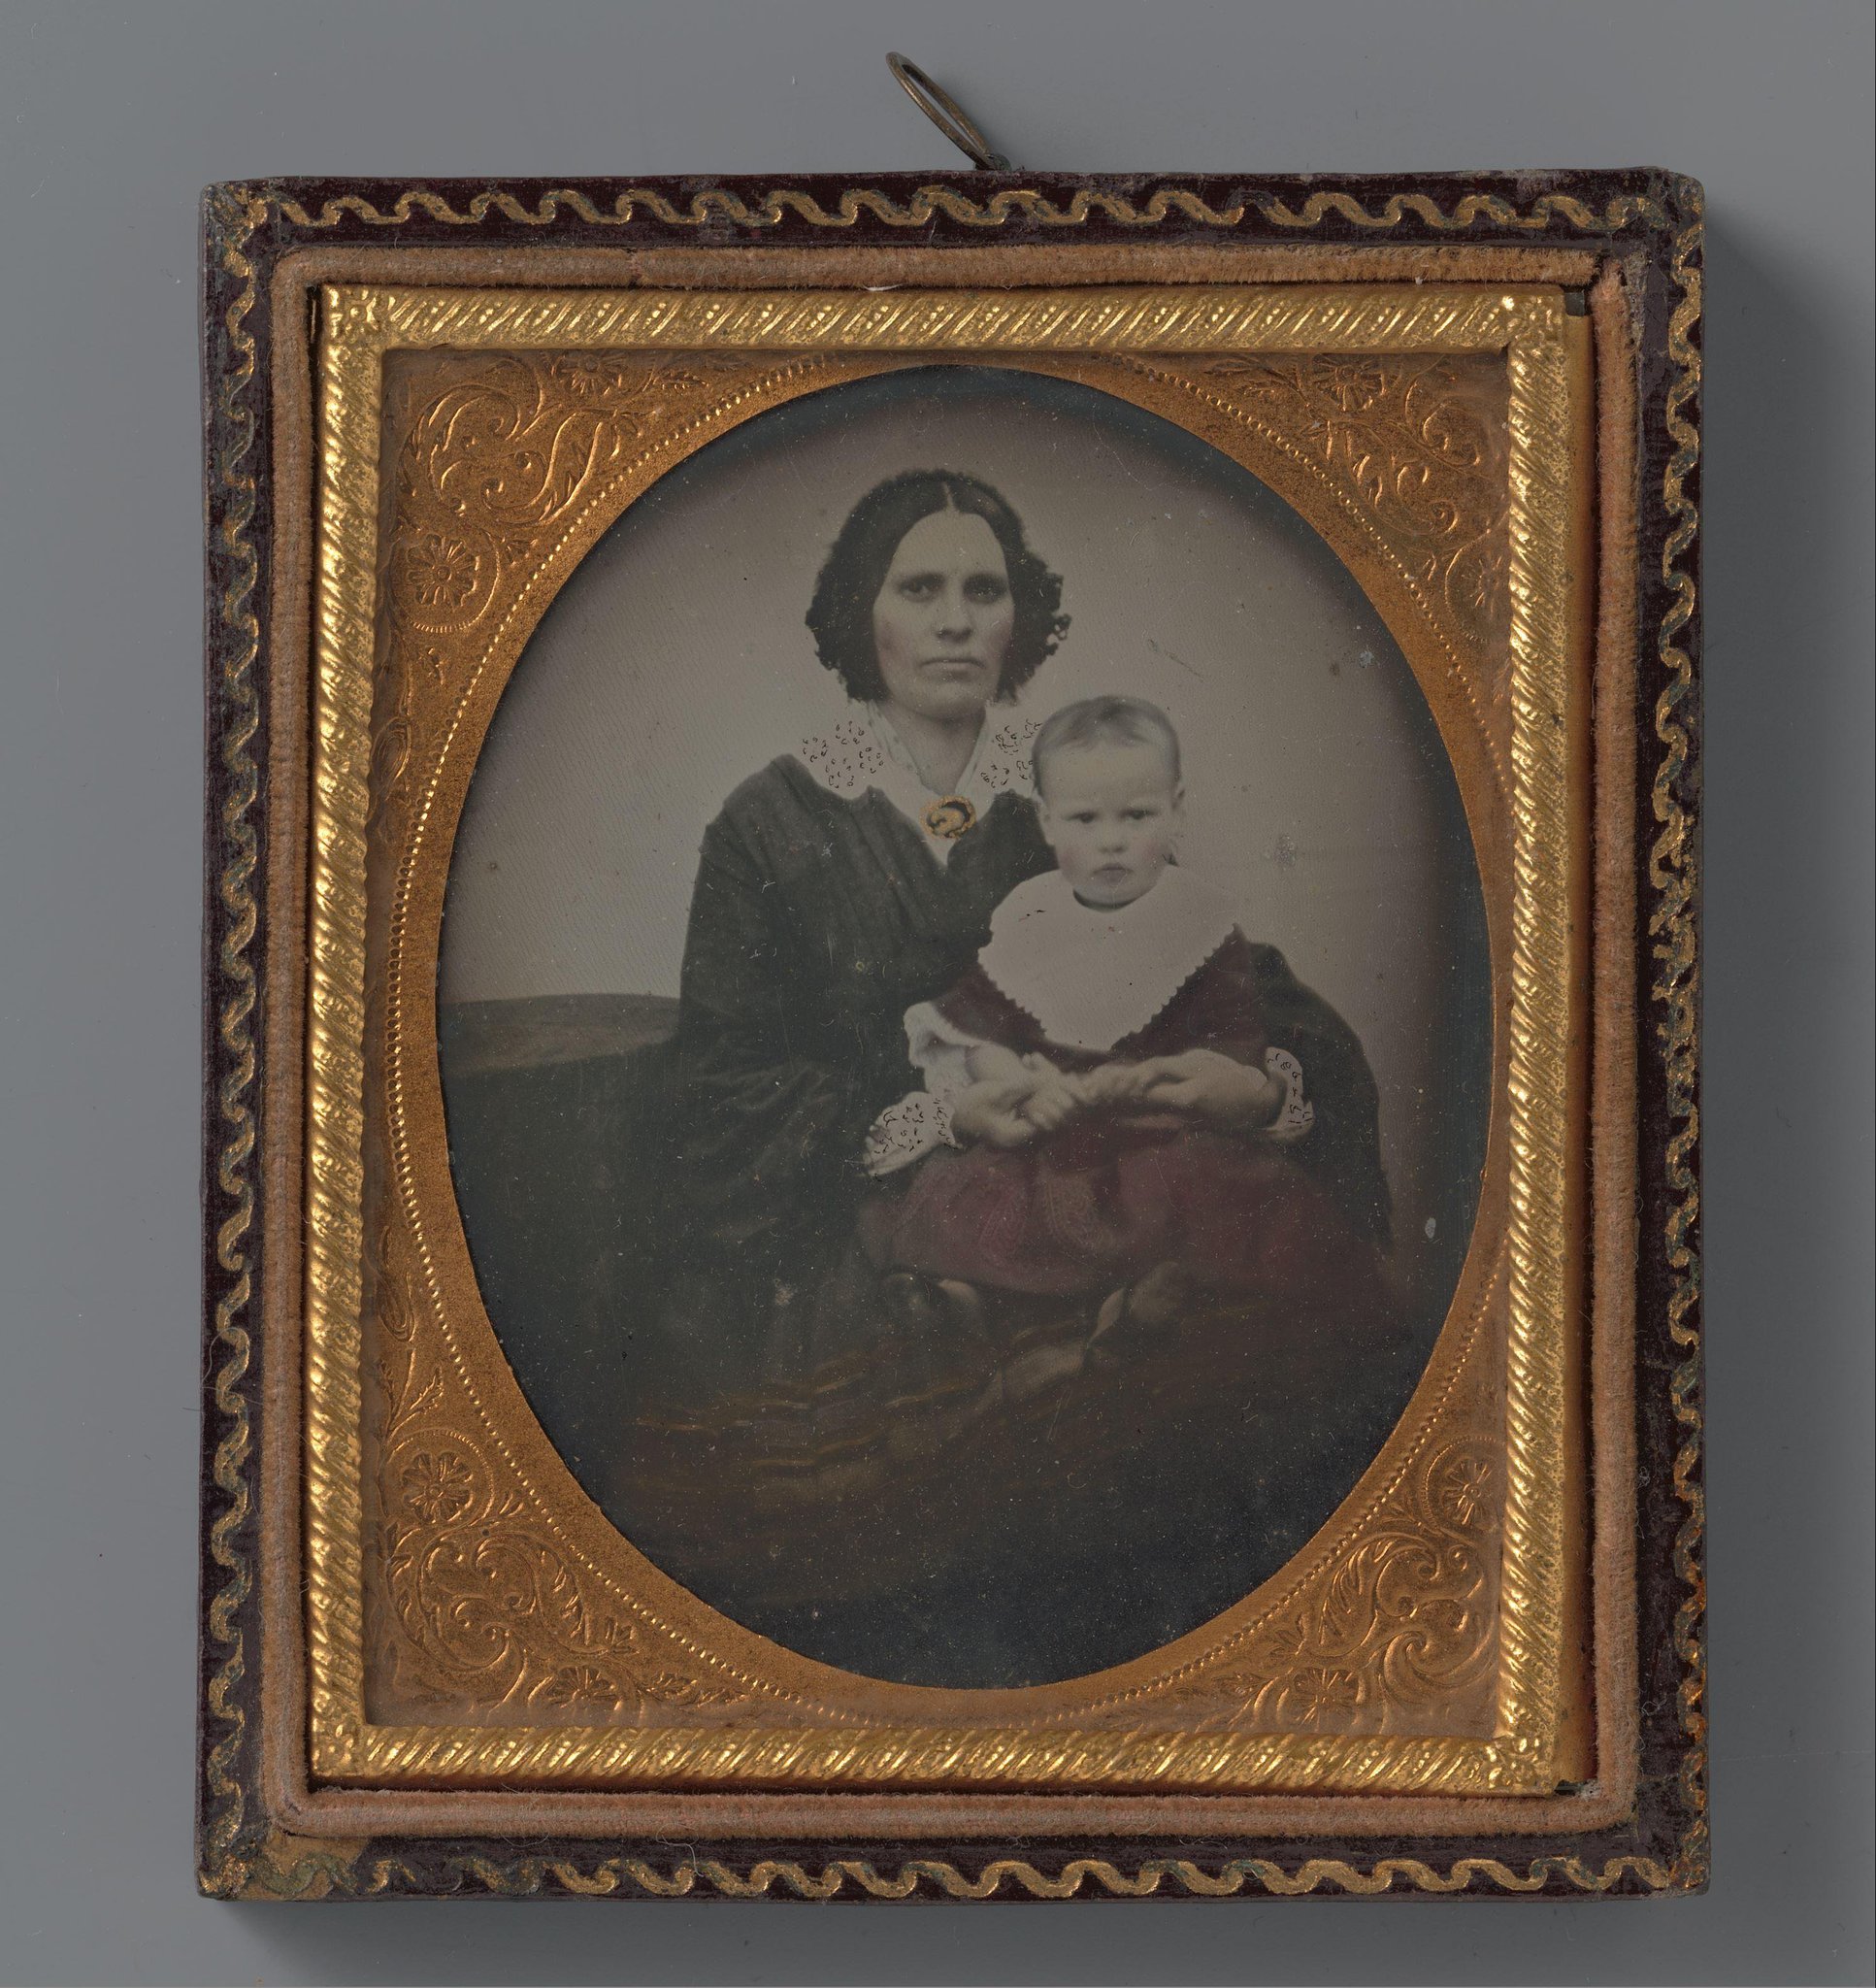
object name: frame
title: Portret van een onbekende vrouw met kind op schoot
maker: Anonymous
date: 1855-1870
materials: glass, metal, velvet, wood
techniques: ambrotype, hand coloring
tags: historical persons - bb - woman, mother and baby or young child, tot, toddler ~ the ages of man